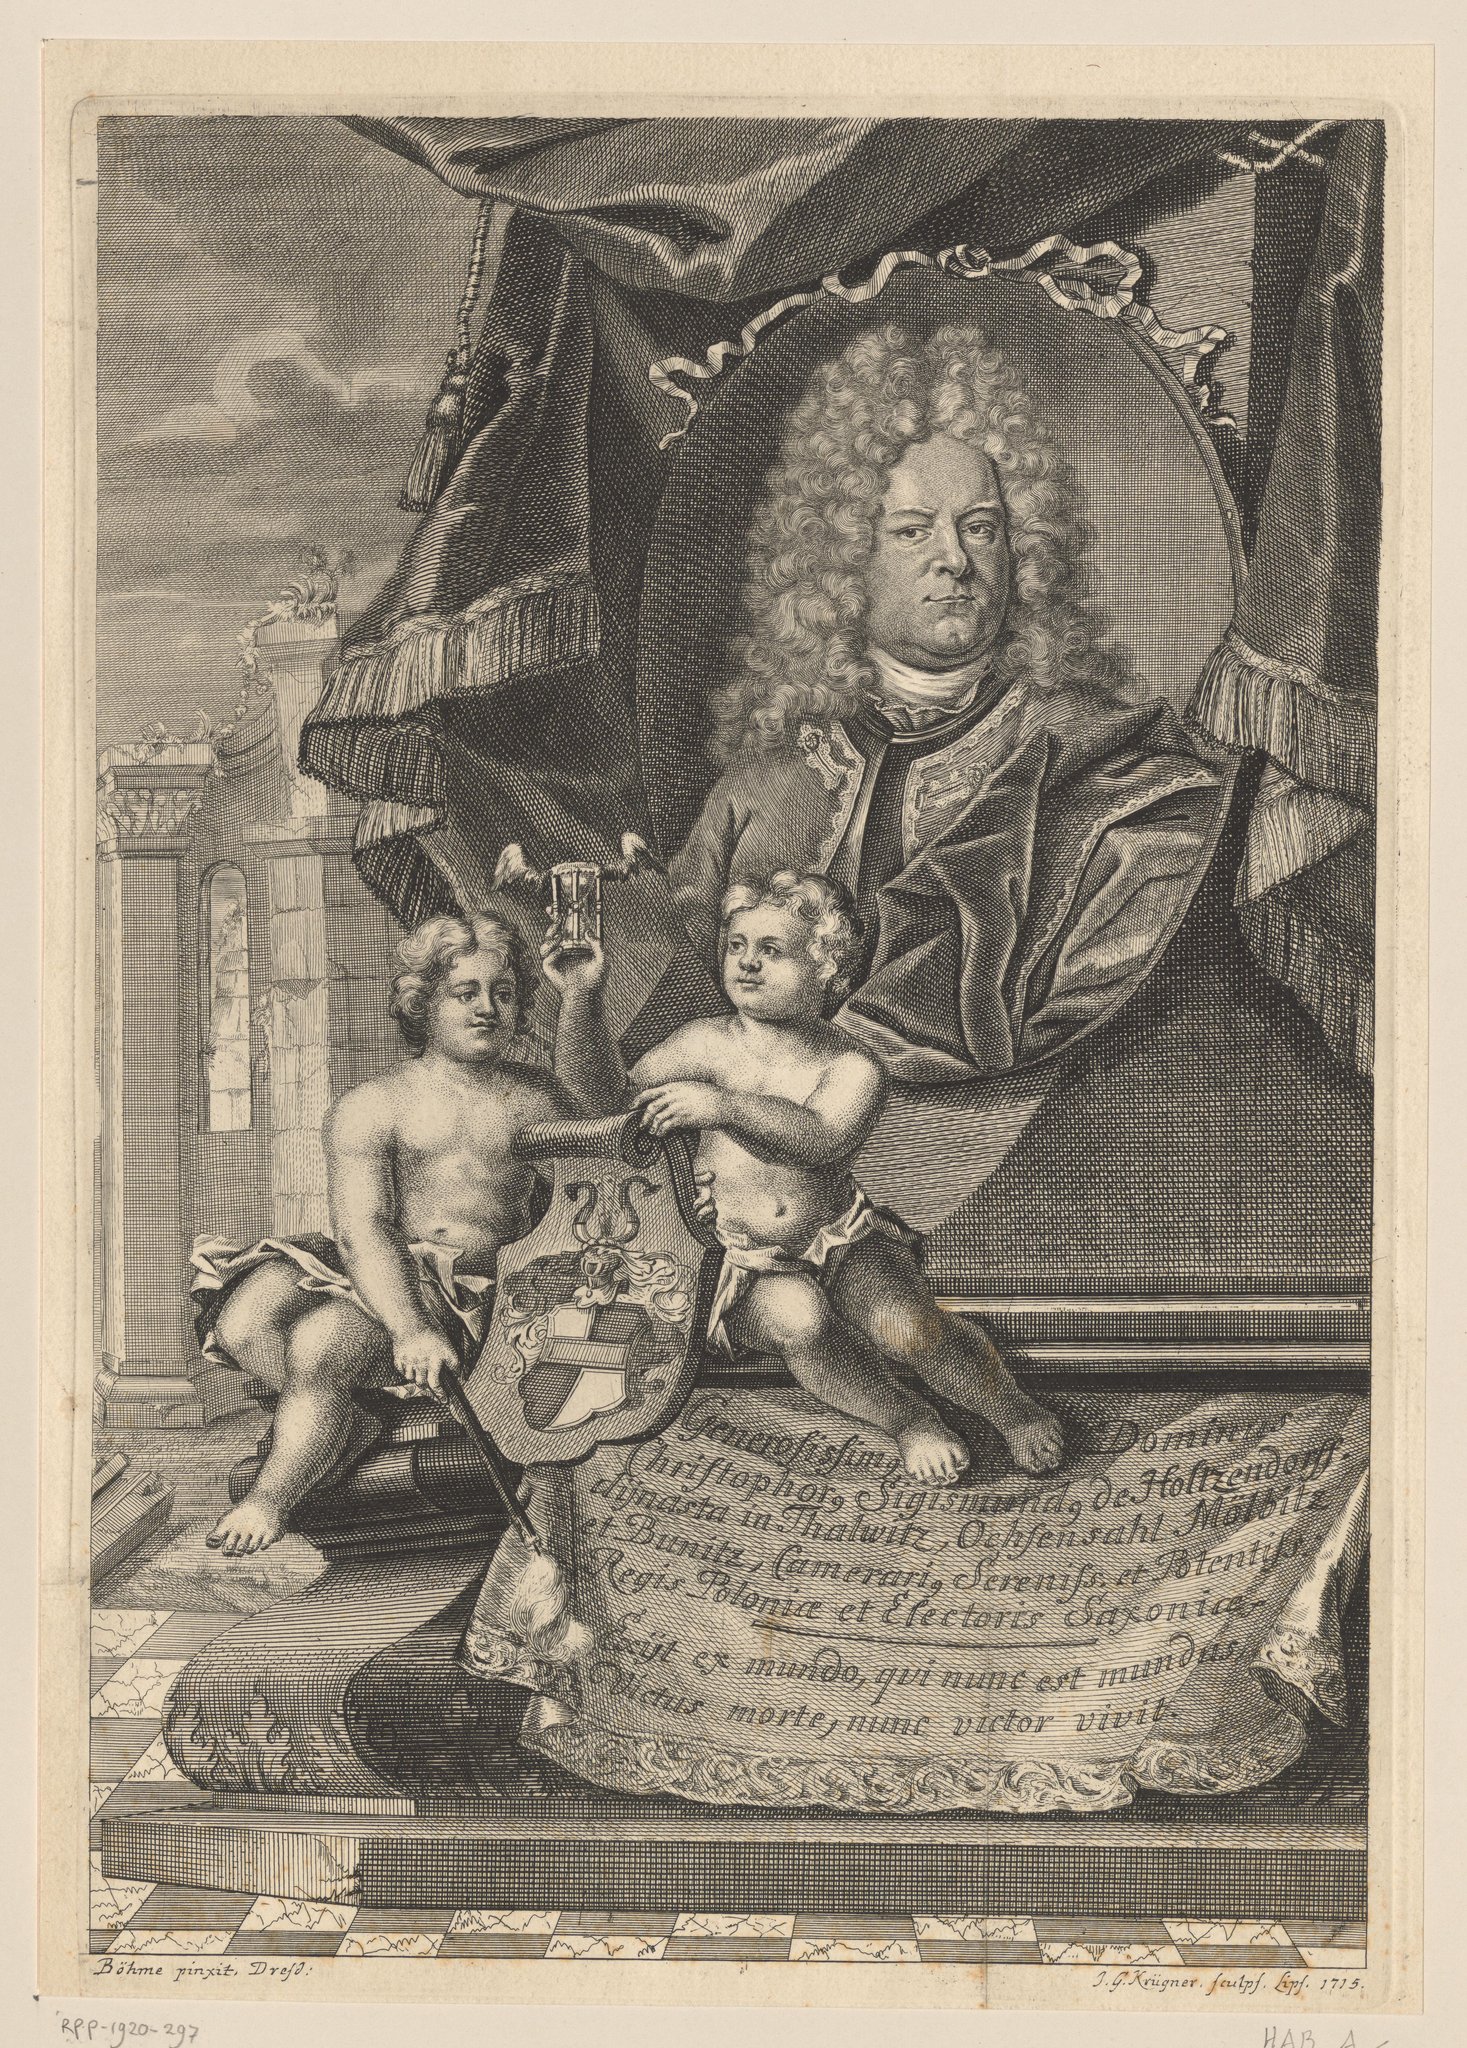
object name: print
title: Portret van Christoph Sigmund von Holtzendorff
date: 1715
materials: paper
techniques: engraving, etching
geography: leipzig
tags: historical persons, ruler, sovereign, cupids: 'amores', 'amoretti', 'putti', armorial bearing, heraldry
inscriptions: collector's mark: Lugt 2228